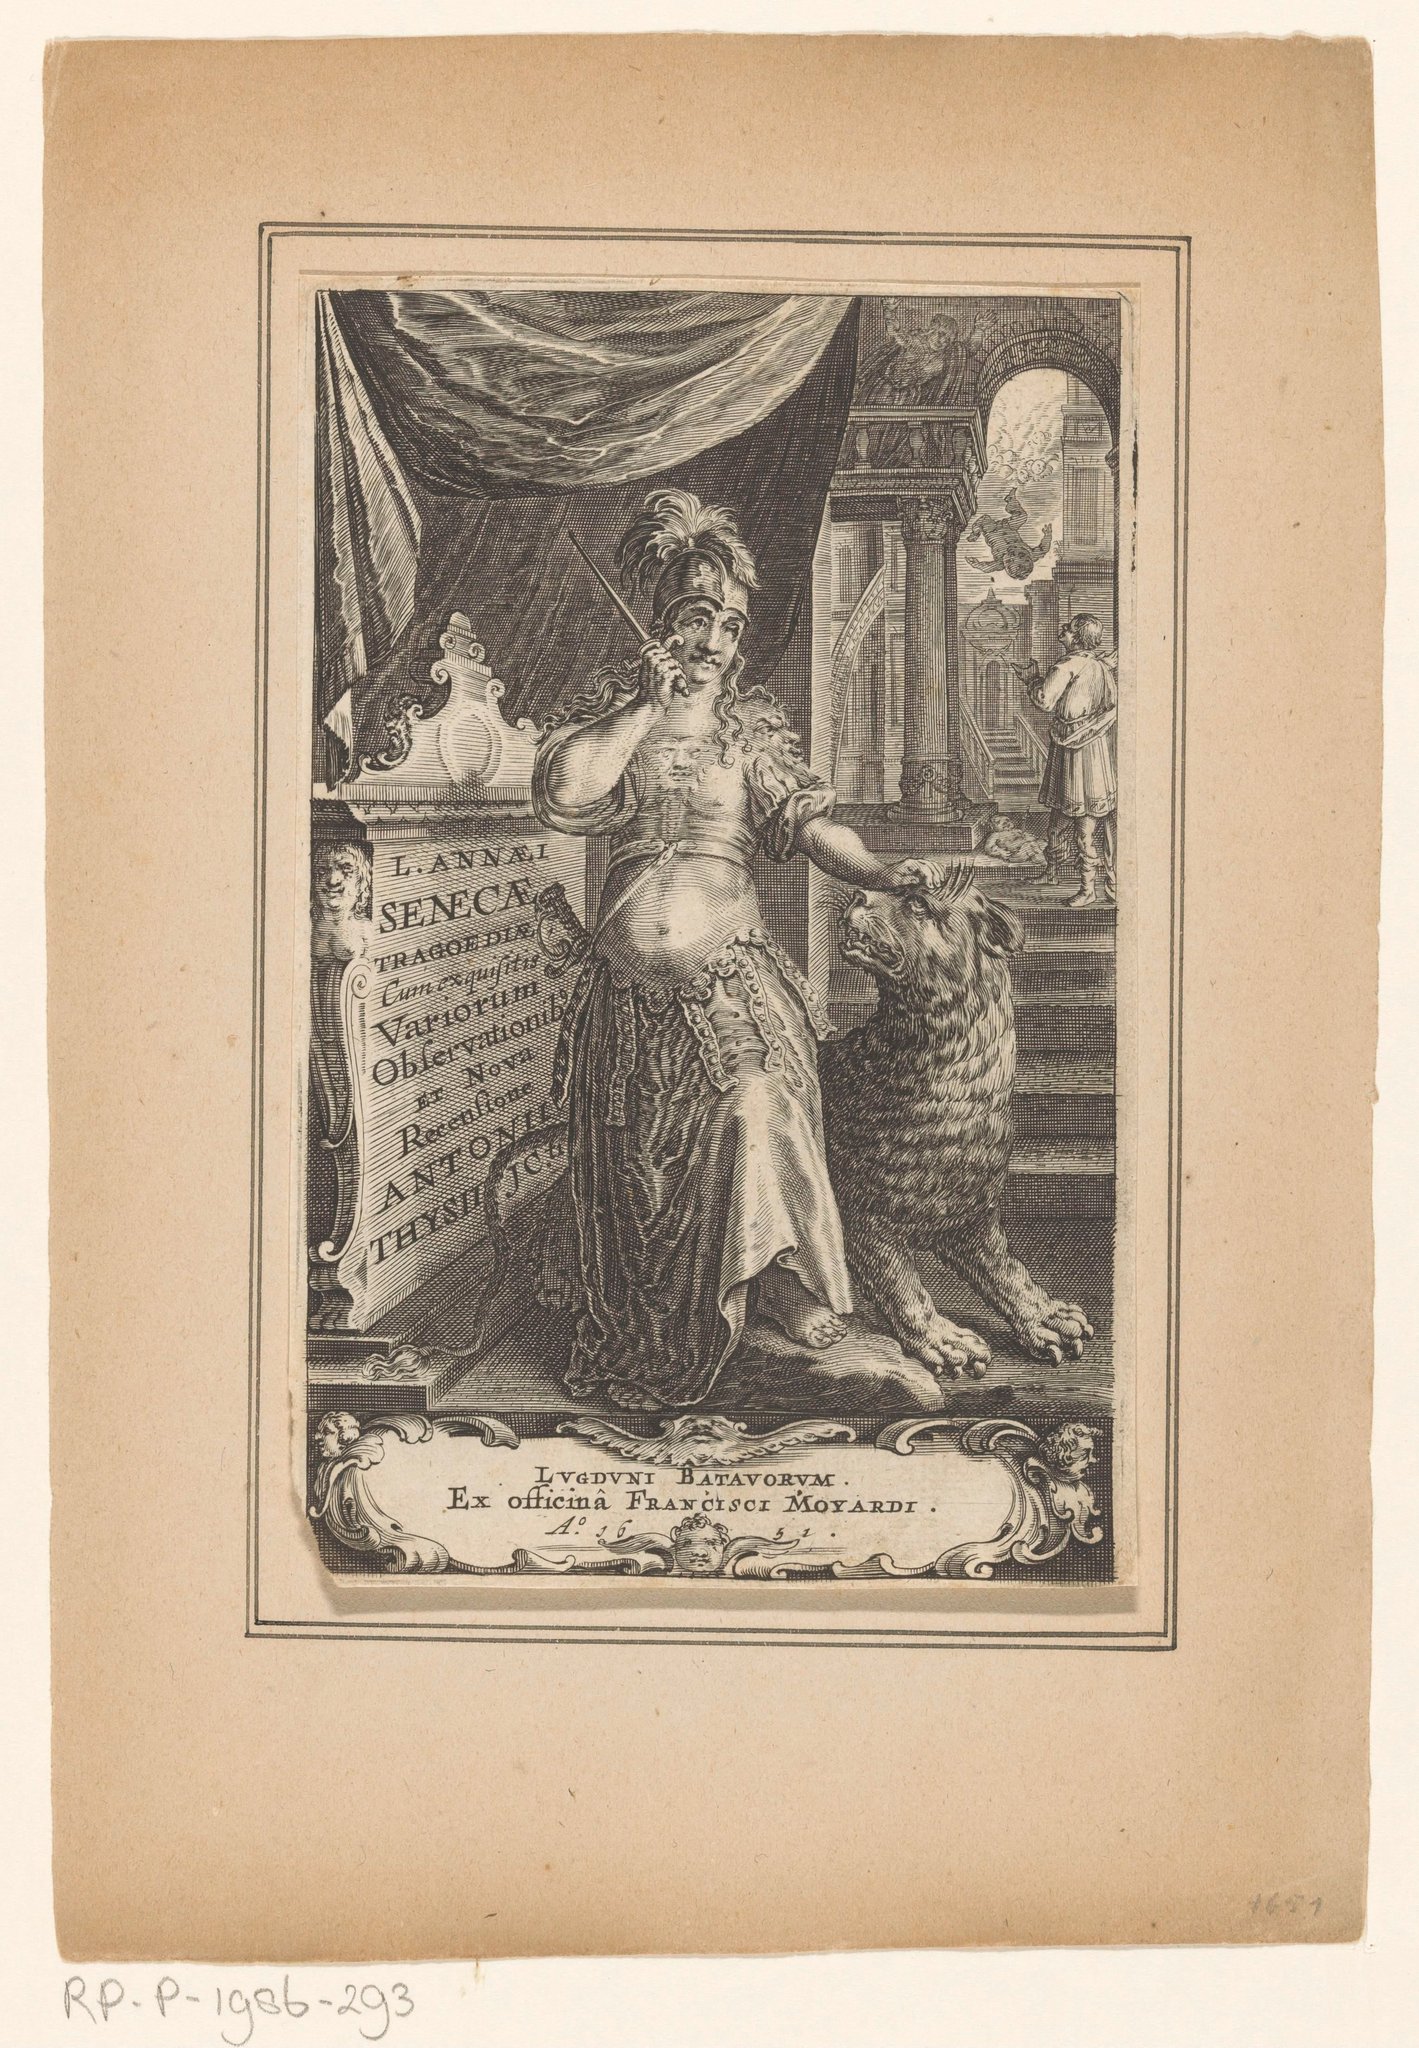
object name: print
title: Titelpagina voor: Lucius Annaeus Seneca en Antonius Thysius, L. Annaei Senecae tragoediae, 1651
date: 1651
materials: paper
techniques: engraving, etching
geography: leiden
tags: standing figure - aa - female human figure, beasts of prey, predatory animals: lion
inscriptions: collector's mark: Lugt 2228, collector's mark: Lugt 2760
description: Een vrouw in harnas met zwaard en leeuw. In de achtergrond staat een man met opgeheven handen bij een neergestoken kind en kijkt naar boven. Een tweede kind valt naar beneden. Op een balkon staat een tweede figuur.